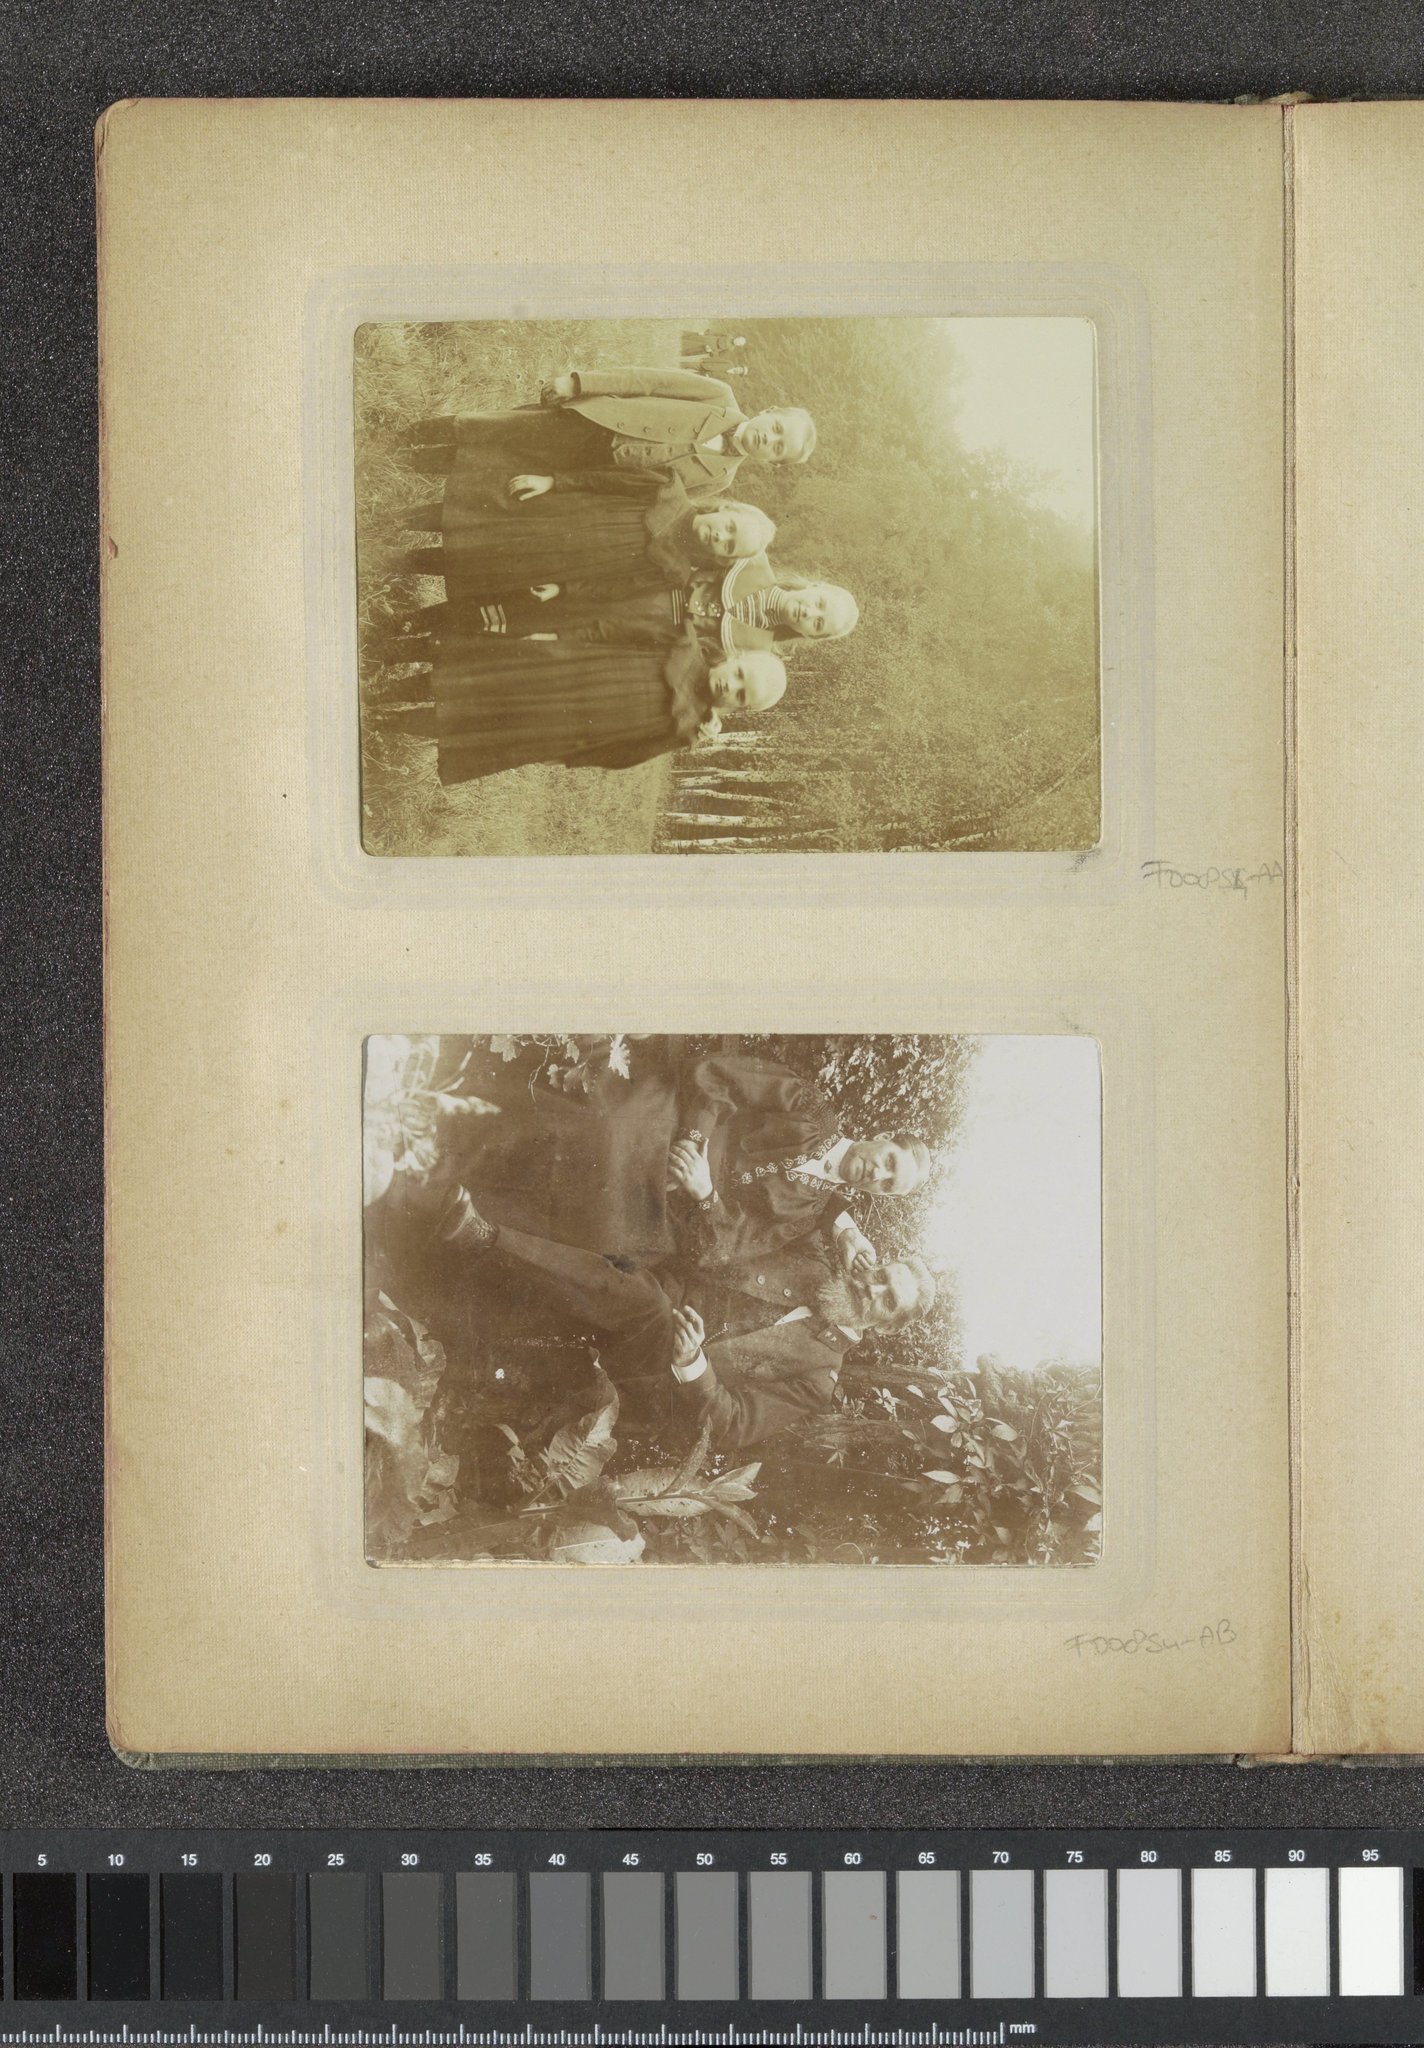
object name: photograph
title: Portret van een ouder echtpaar zittend te midden van planten in Duitsland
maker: Anonymous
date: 1890-1910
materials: cardboard, paper, photographic support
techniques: collodion silver print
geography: germany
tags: plants; vegetation, marriage, married couple, 'matrimonium', germany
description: Onderdeel van Fotoalbum van Carl Heinrich Fliegenschmidt, gevangenisdirecteur te Oslebshausen.